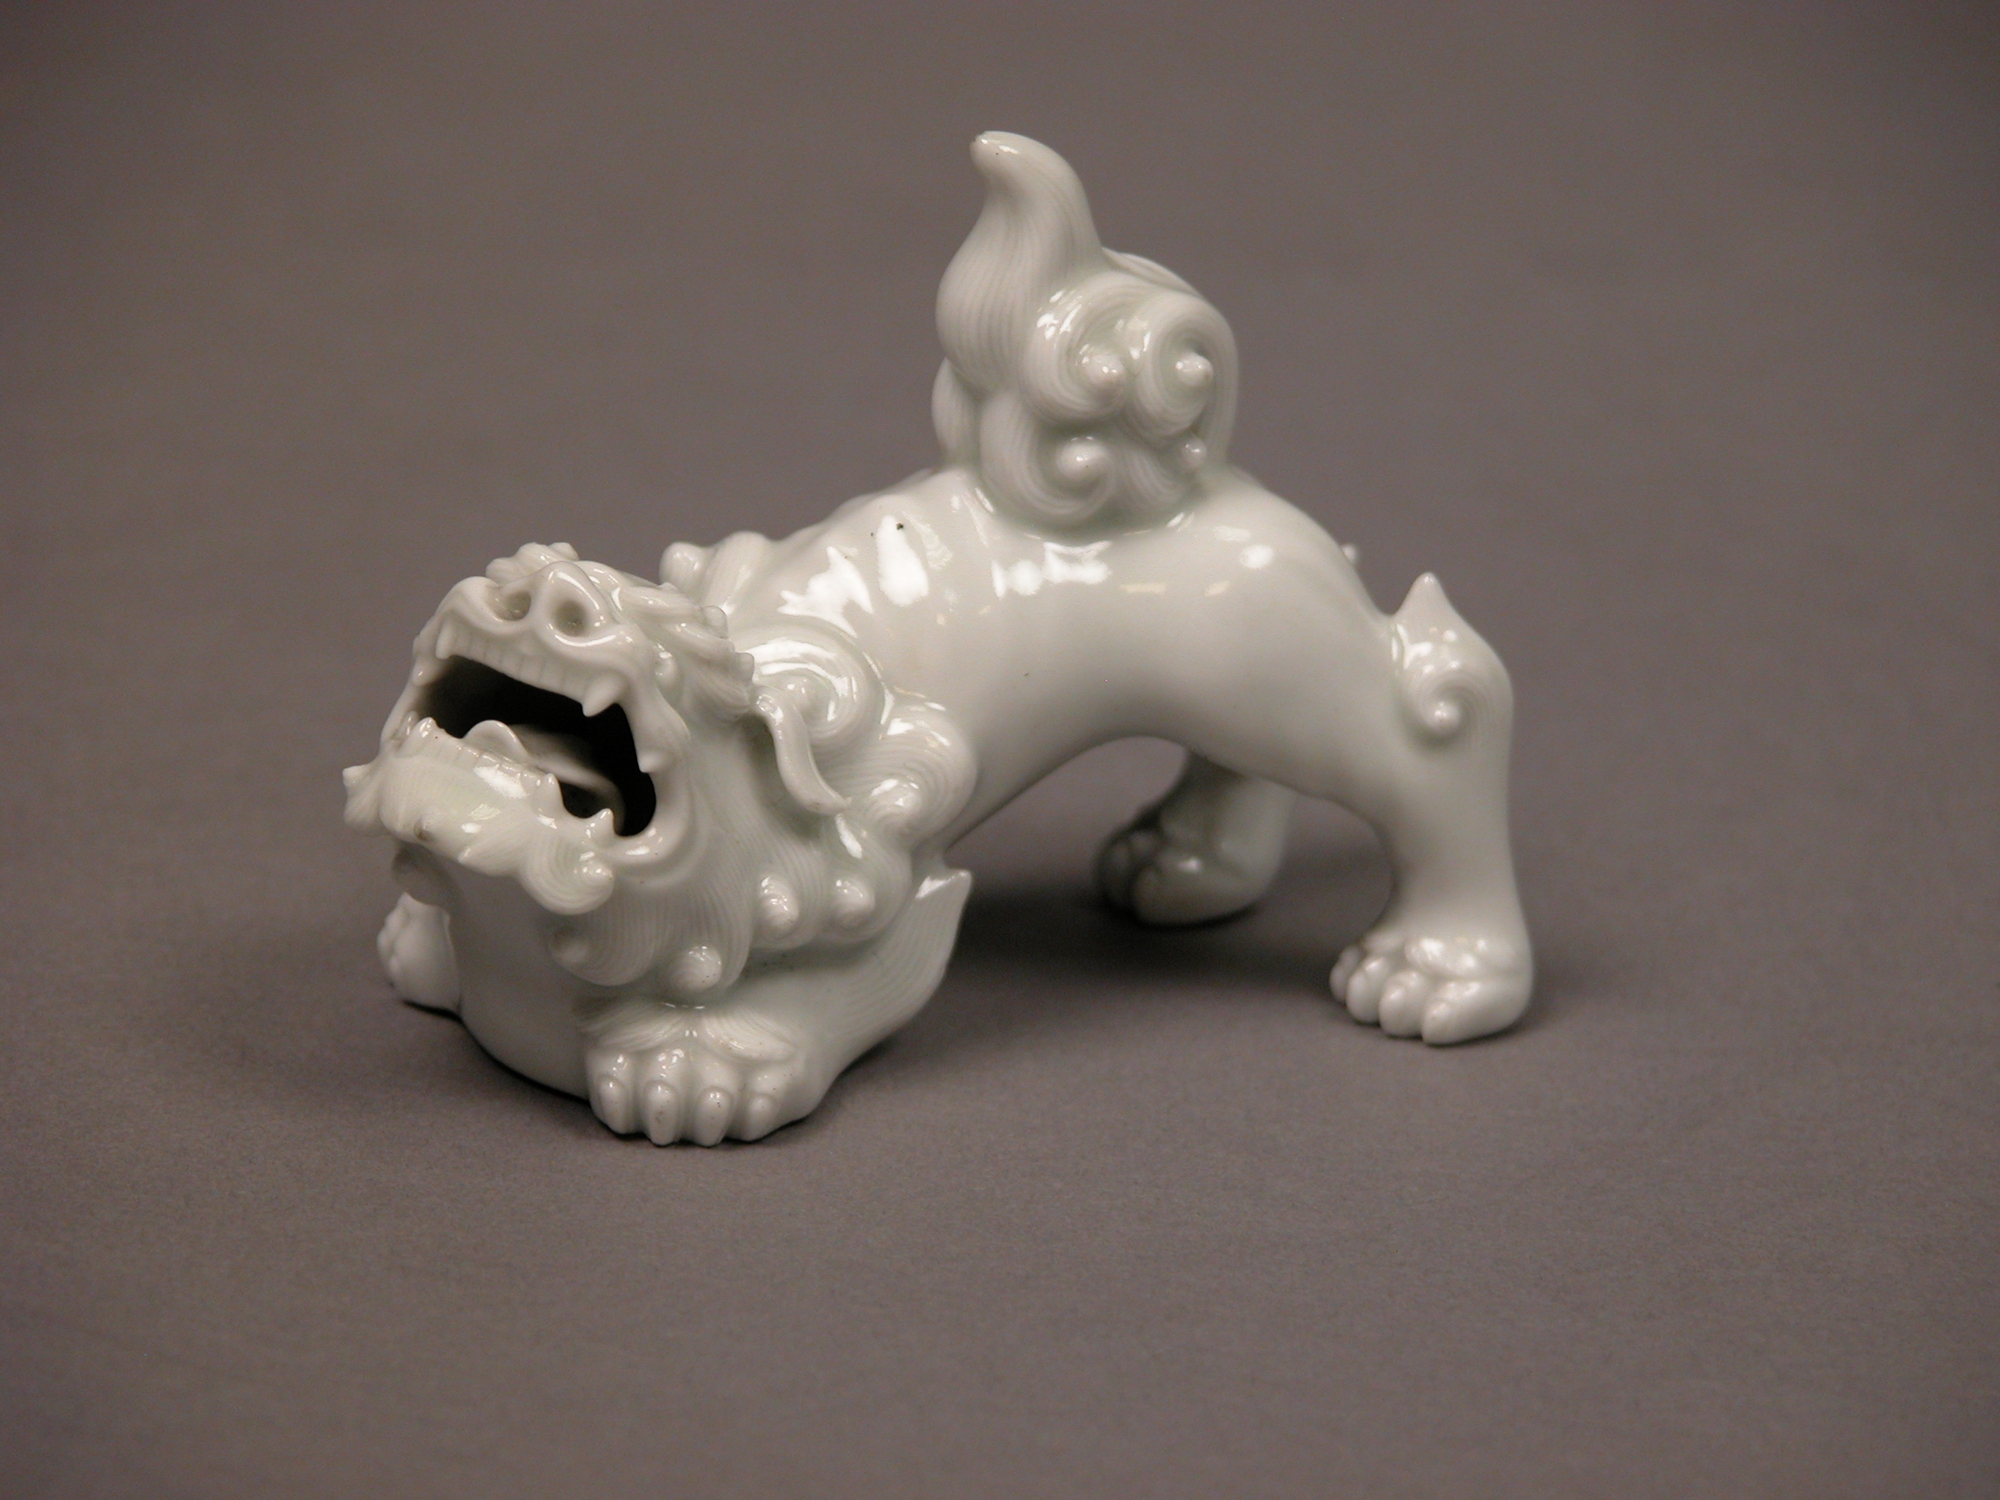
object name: figure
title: Chinese Lion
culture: japanese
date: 1701-1800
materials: porcelain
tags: lions